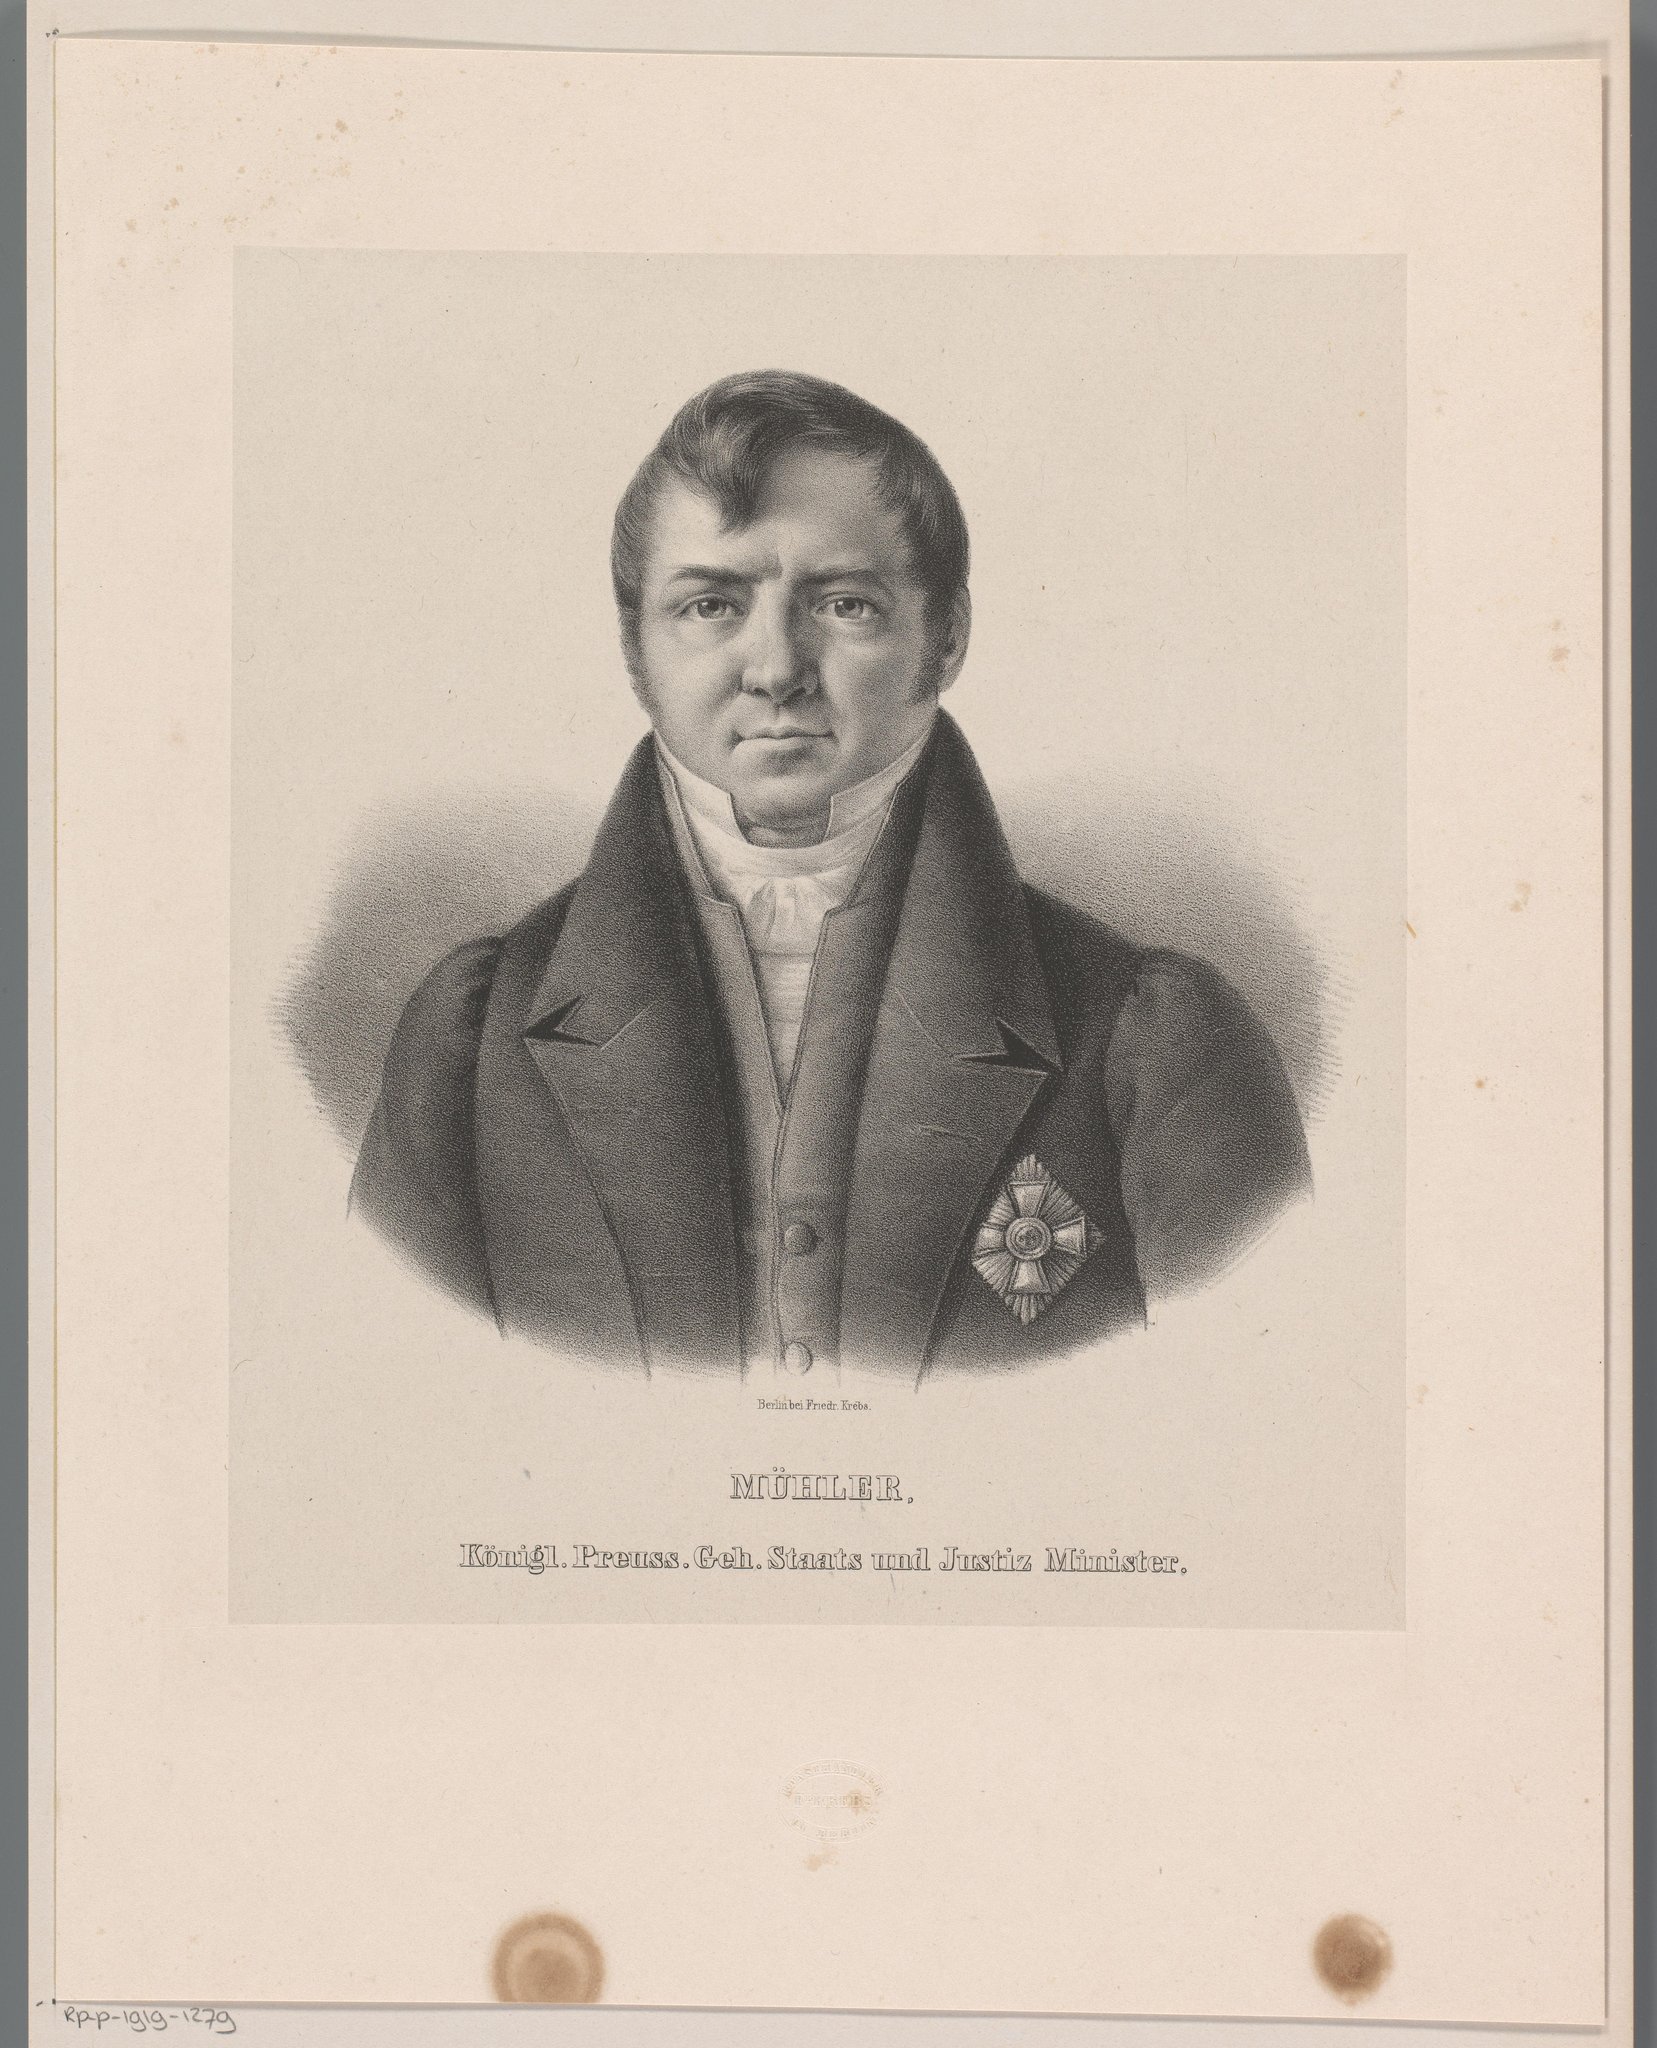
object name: print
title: Mühler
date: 1832-1854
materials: paper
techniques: lithograph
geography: berlin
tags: berlin, politician, historical persons, politician, e.g. party leader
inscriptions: check stamp: ‘Kunsthändler Fr Krebs in Berlin’